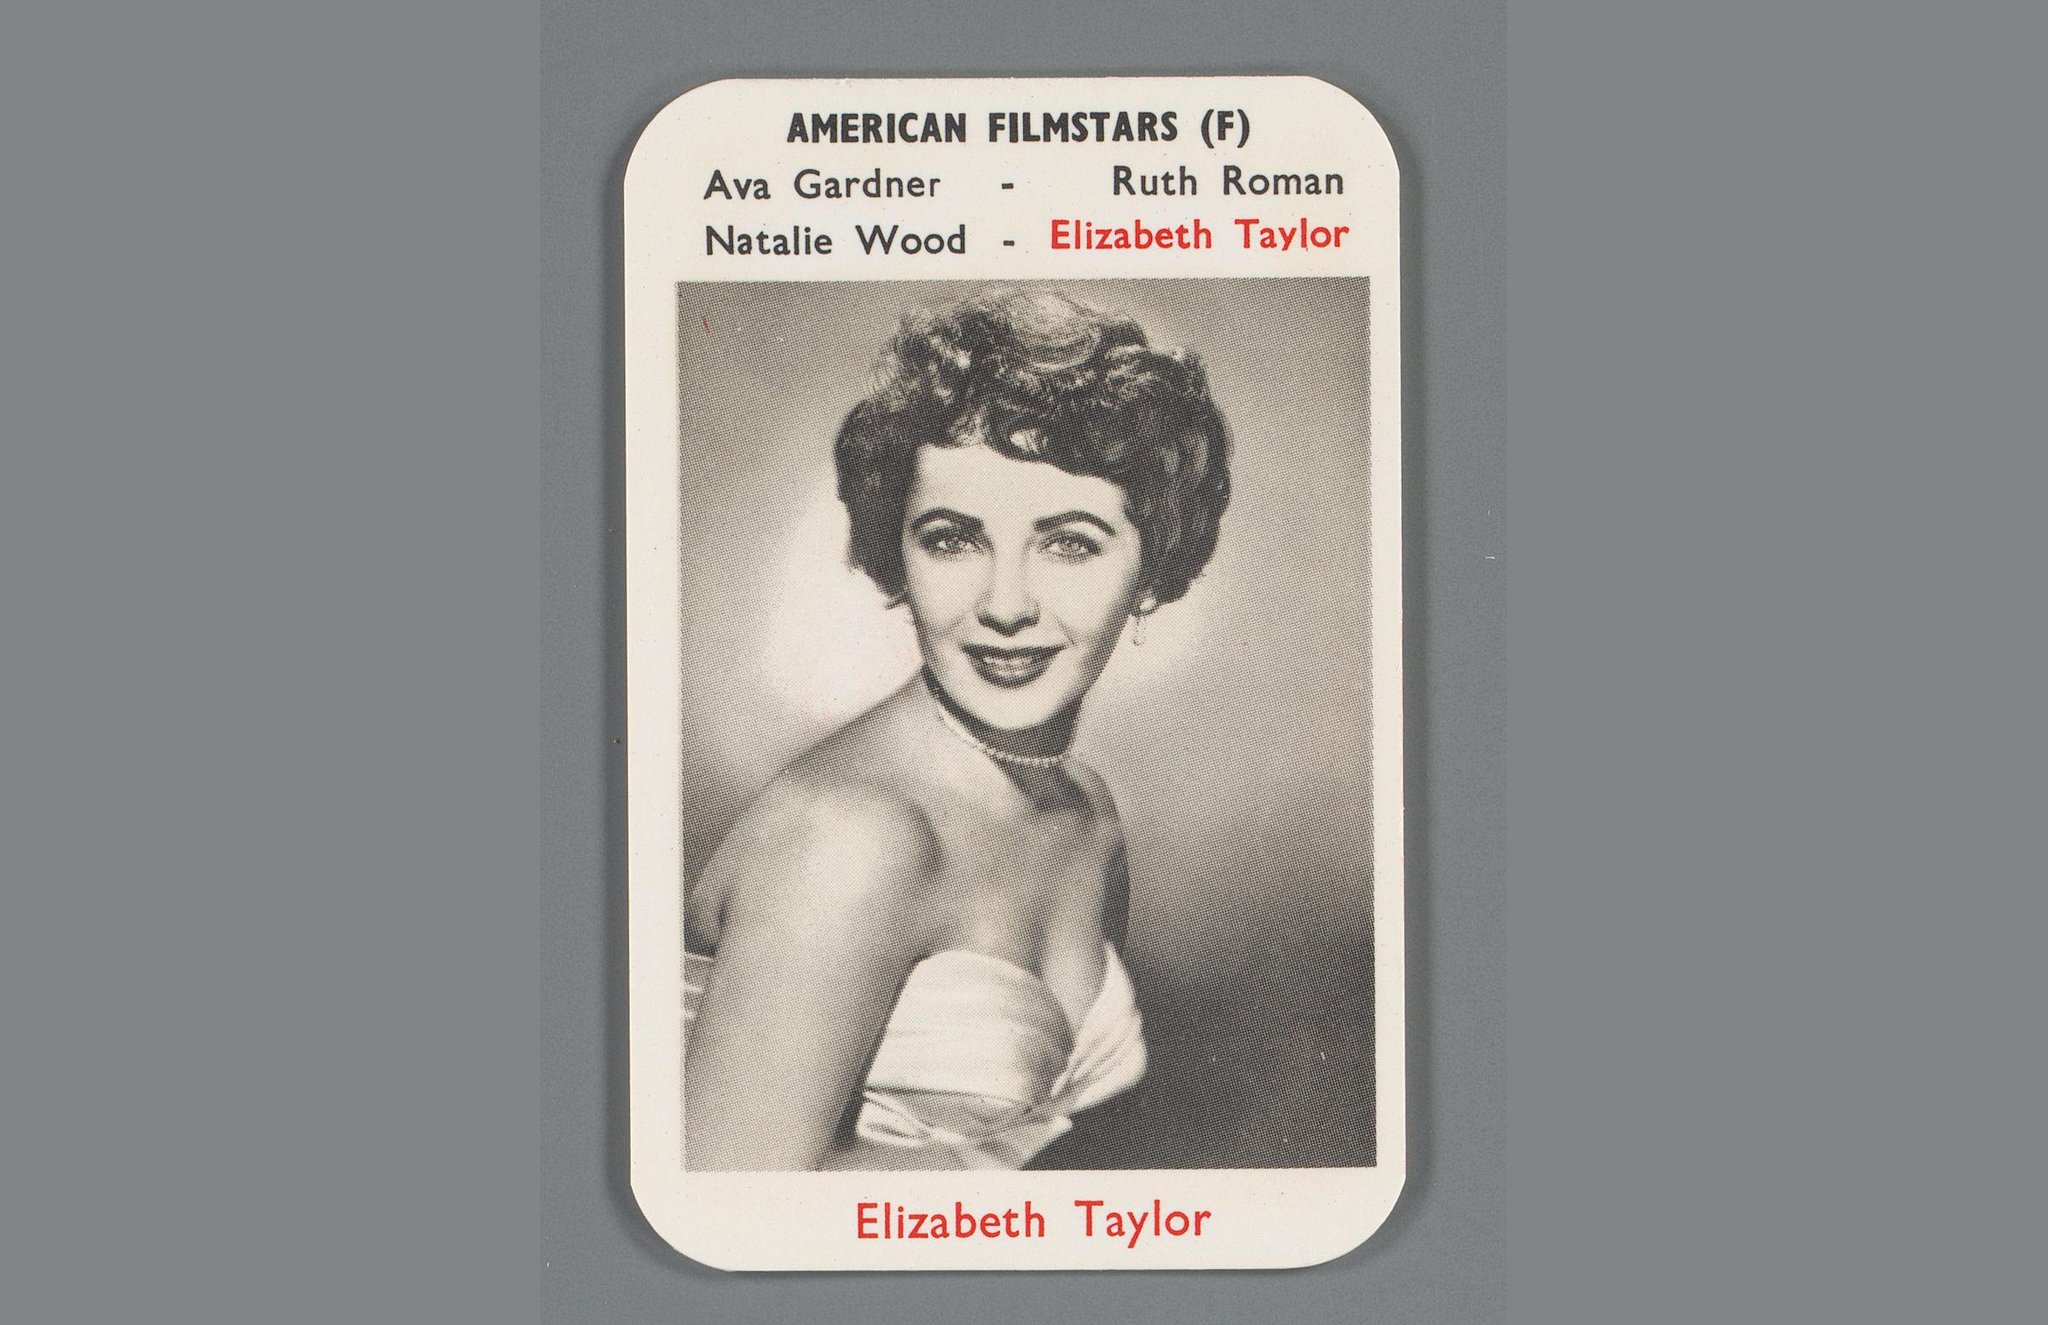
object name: playing card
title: American Filmstars (F)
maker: Anonymous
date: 1960-1970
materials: paper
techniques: autotype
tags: portrait of actor, actress